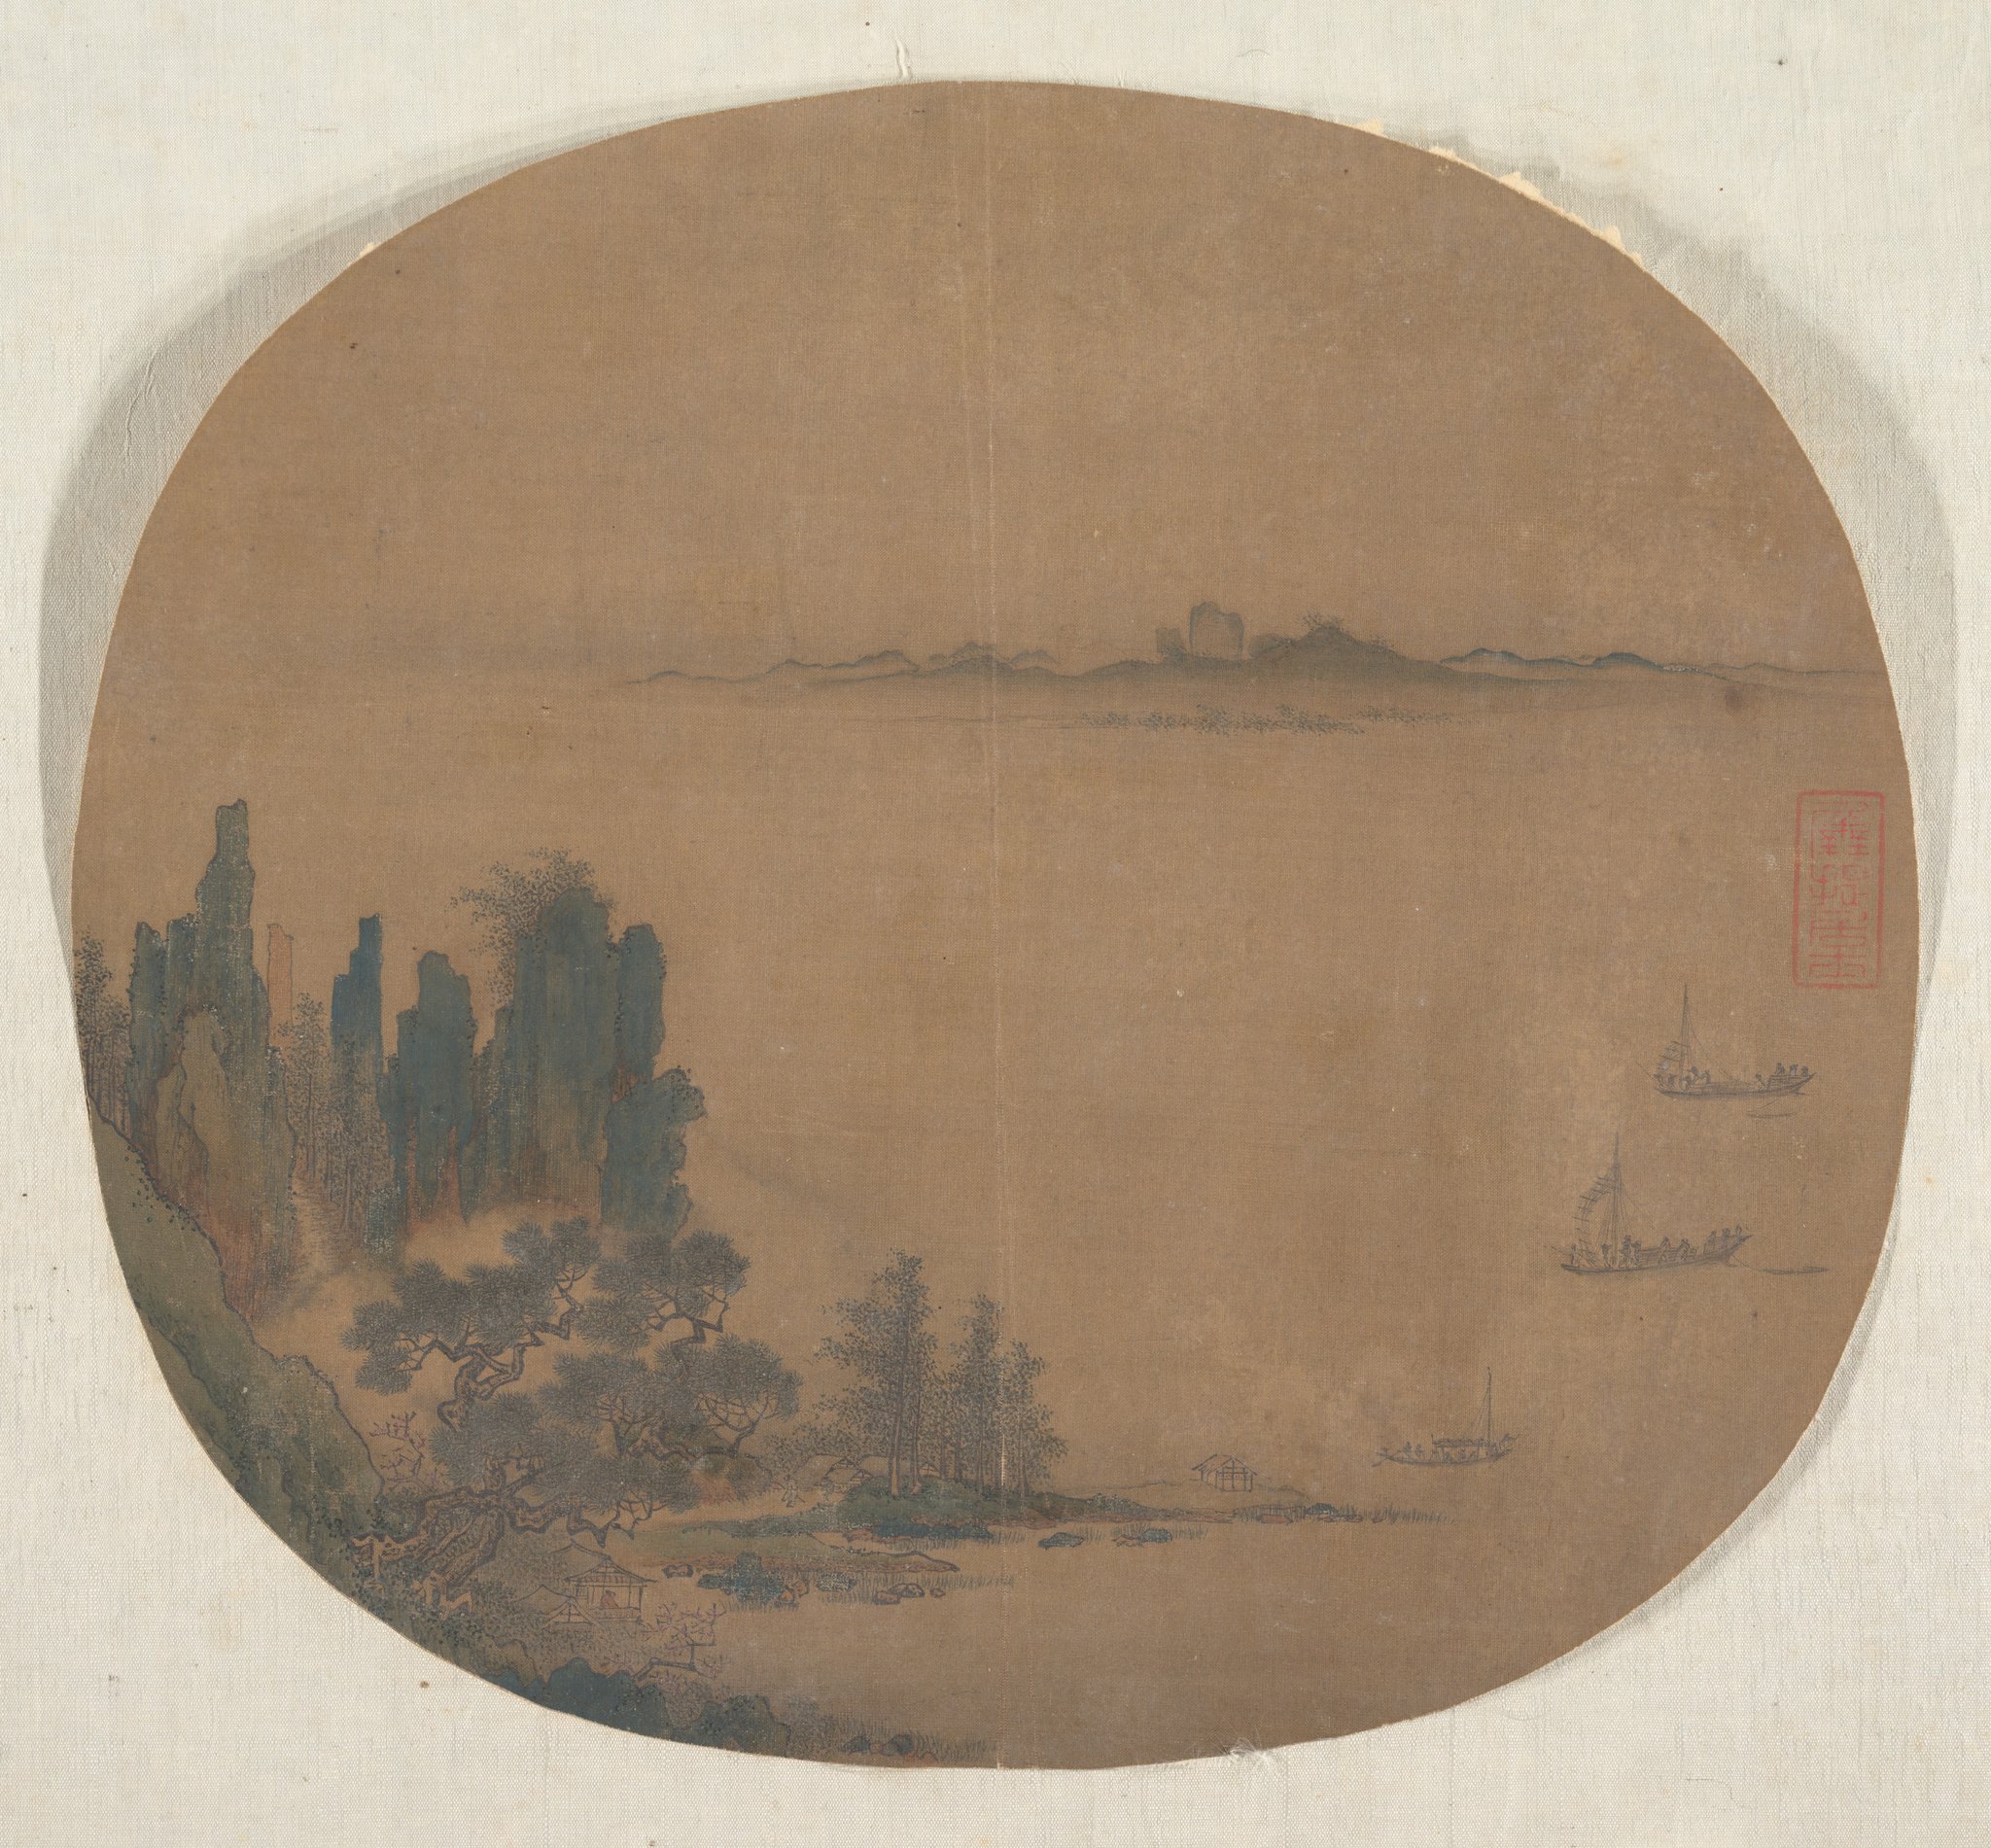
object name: fan mounted a an album leaf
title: Seascape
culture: chinese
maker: unidentified artist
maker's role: artist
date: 1368-1644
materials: ink, silk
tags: seascapes,boats